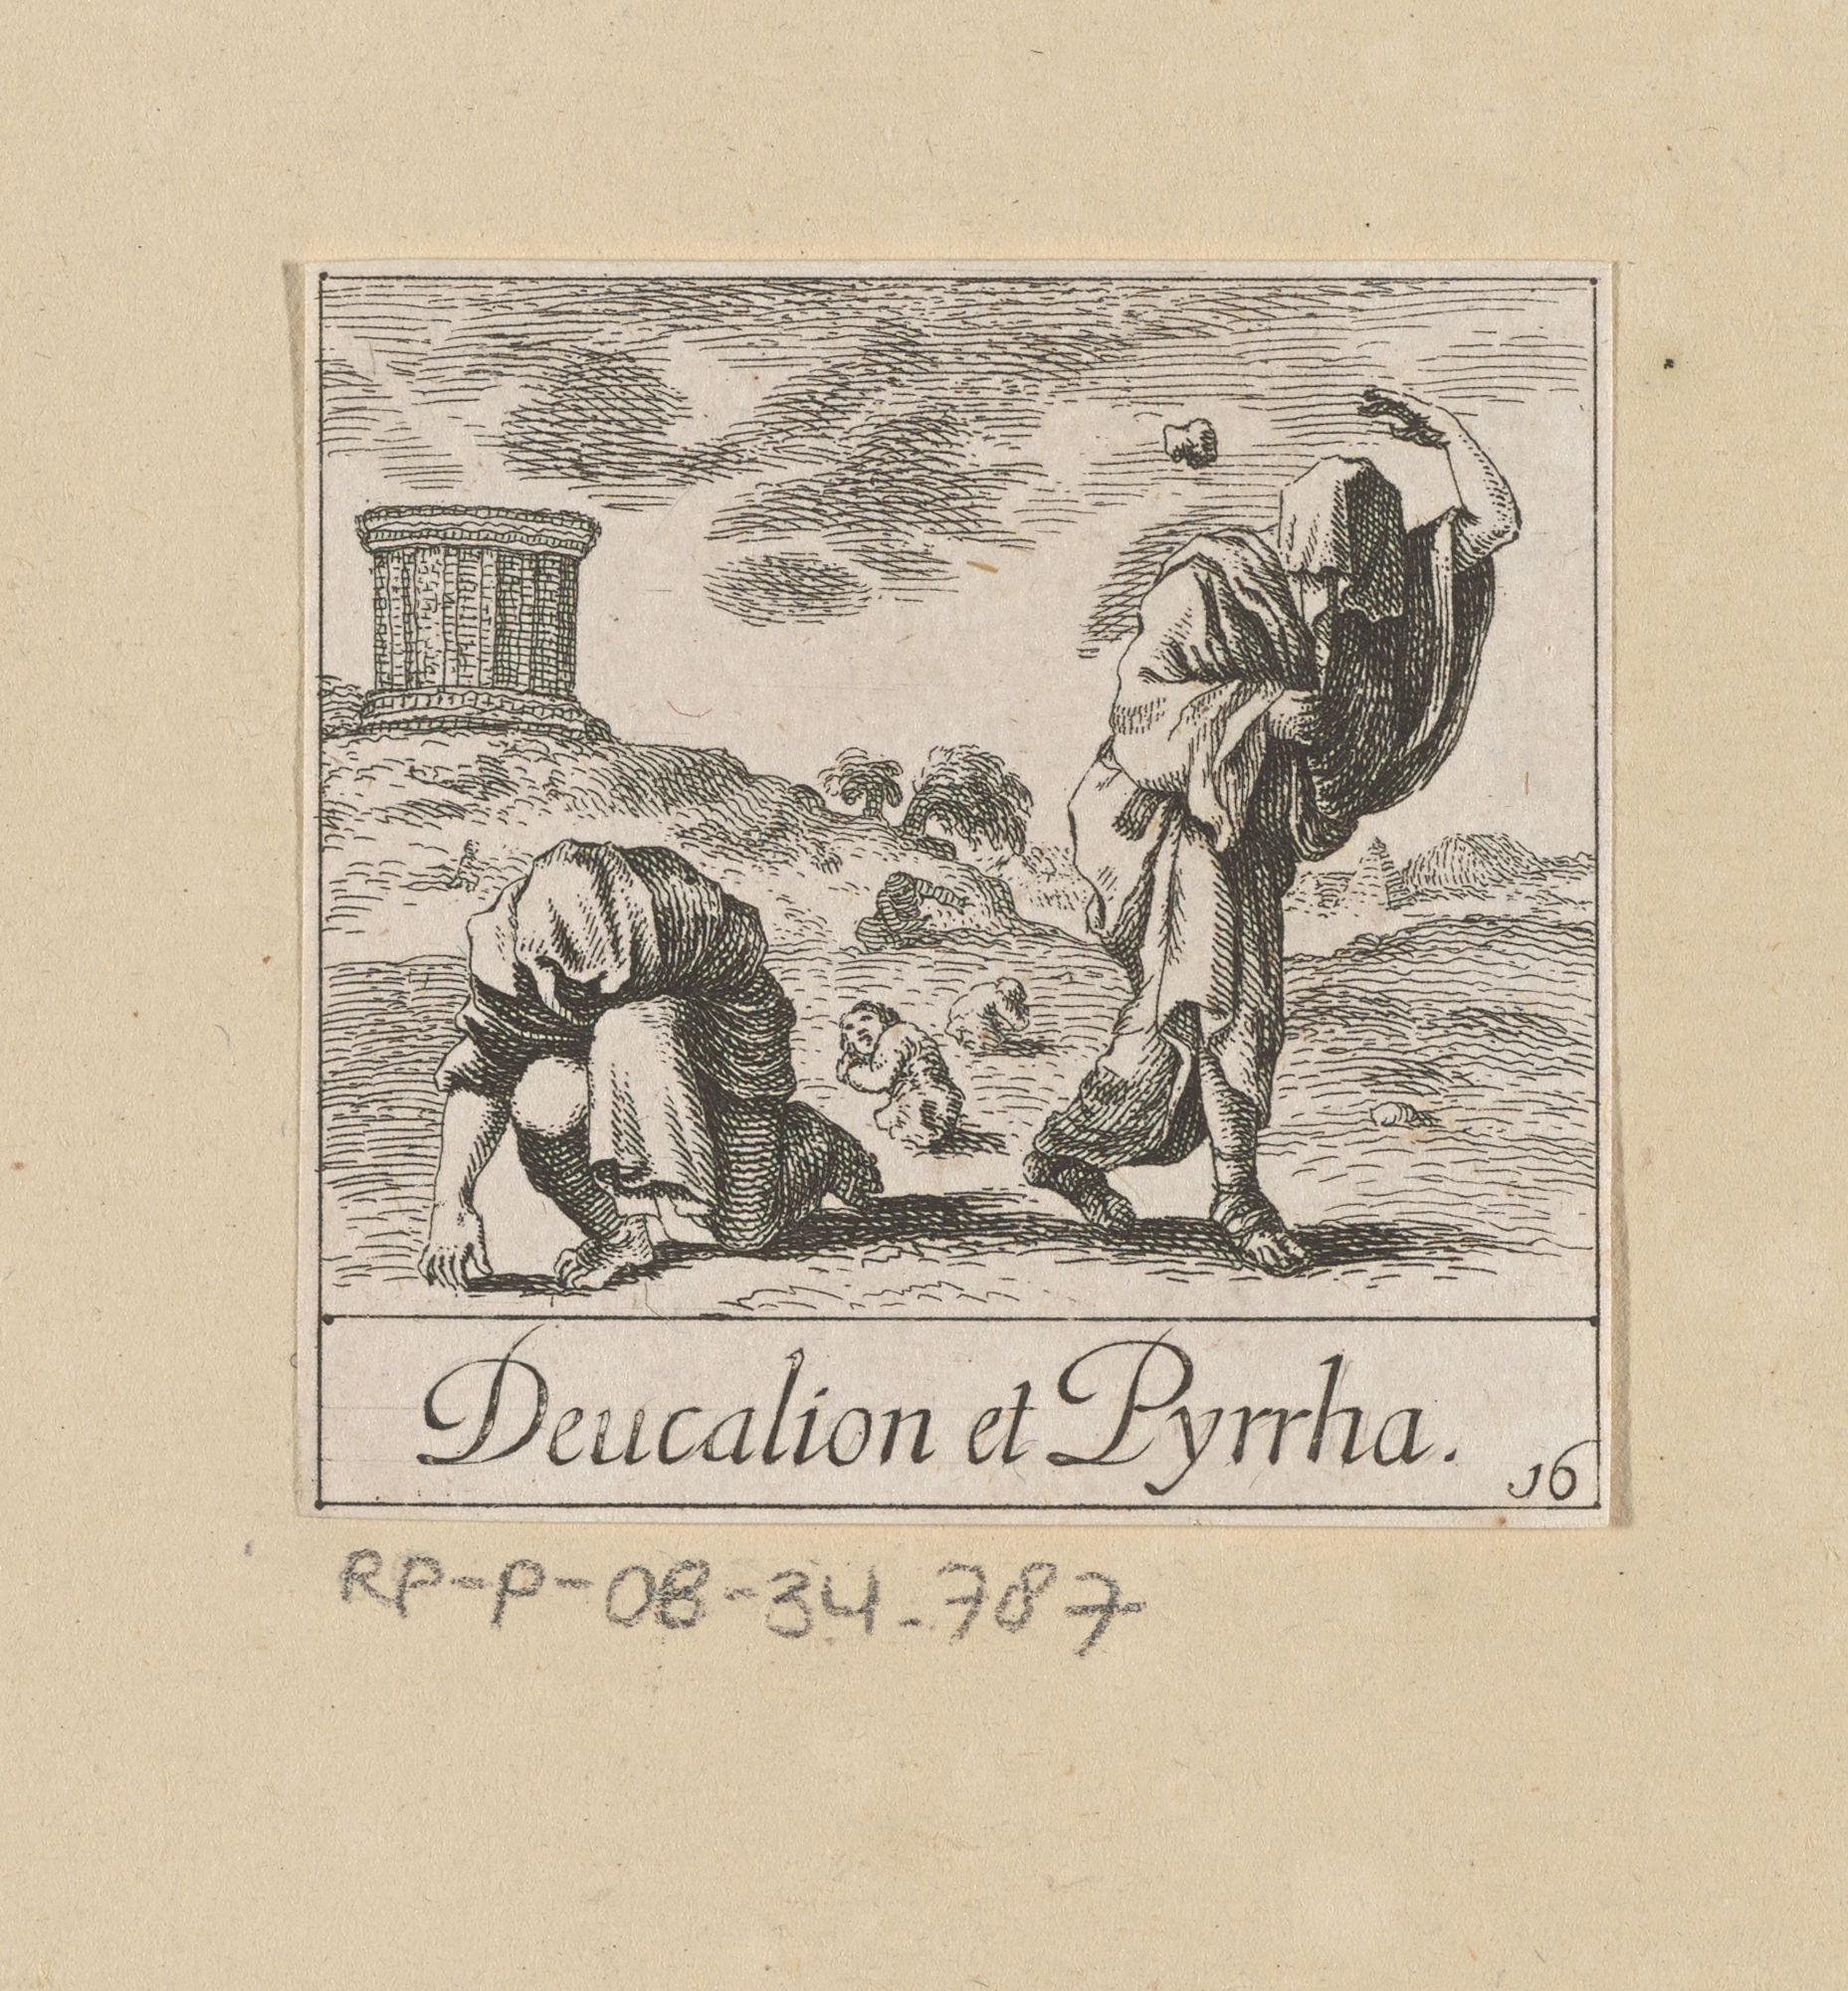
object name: print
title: Deucalion en Pyrrha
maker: Anonymous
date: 1620-1664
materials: paper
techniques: etching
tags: stones turning into men: stones thrown by deucalion and pyrrha, as directed by the oracle of themis, turn into men (ovid, metamorphoses x 400)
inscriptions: collector's mark: Lugt 240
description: Speelkaart met een voorstelling van Deucalion en Pyrrha die met stenen gooien die in mensen veranderen. Op de achtergrond een tempel.